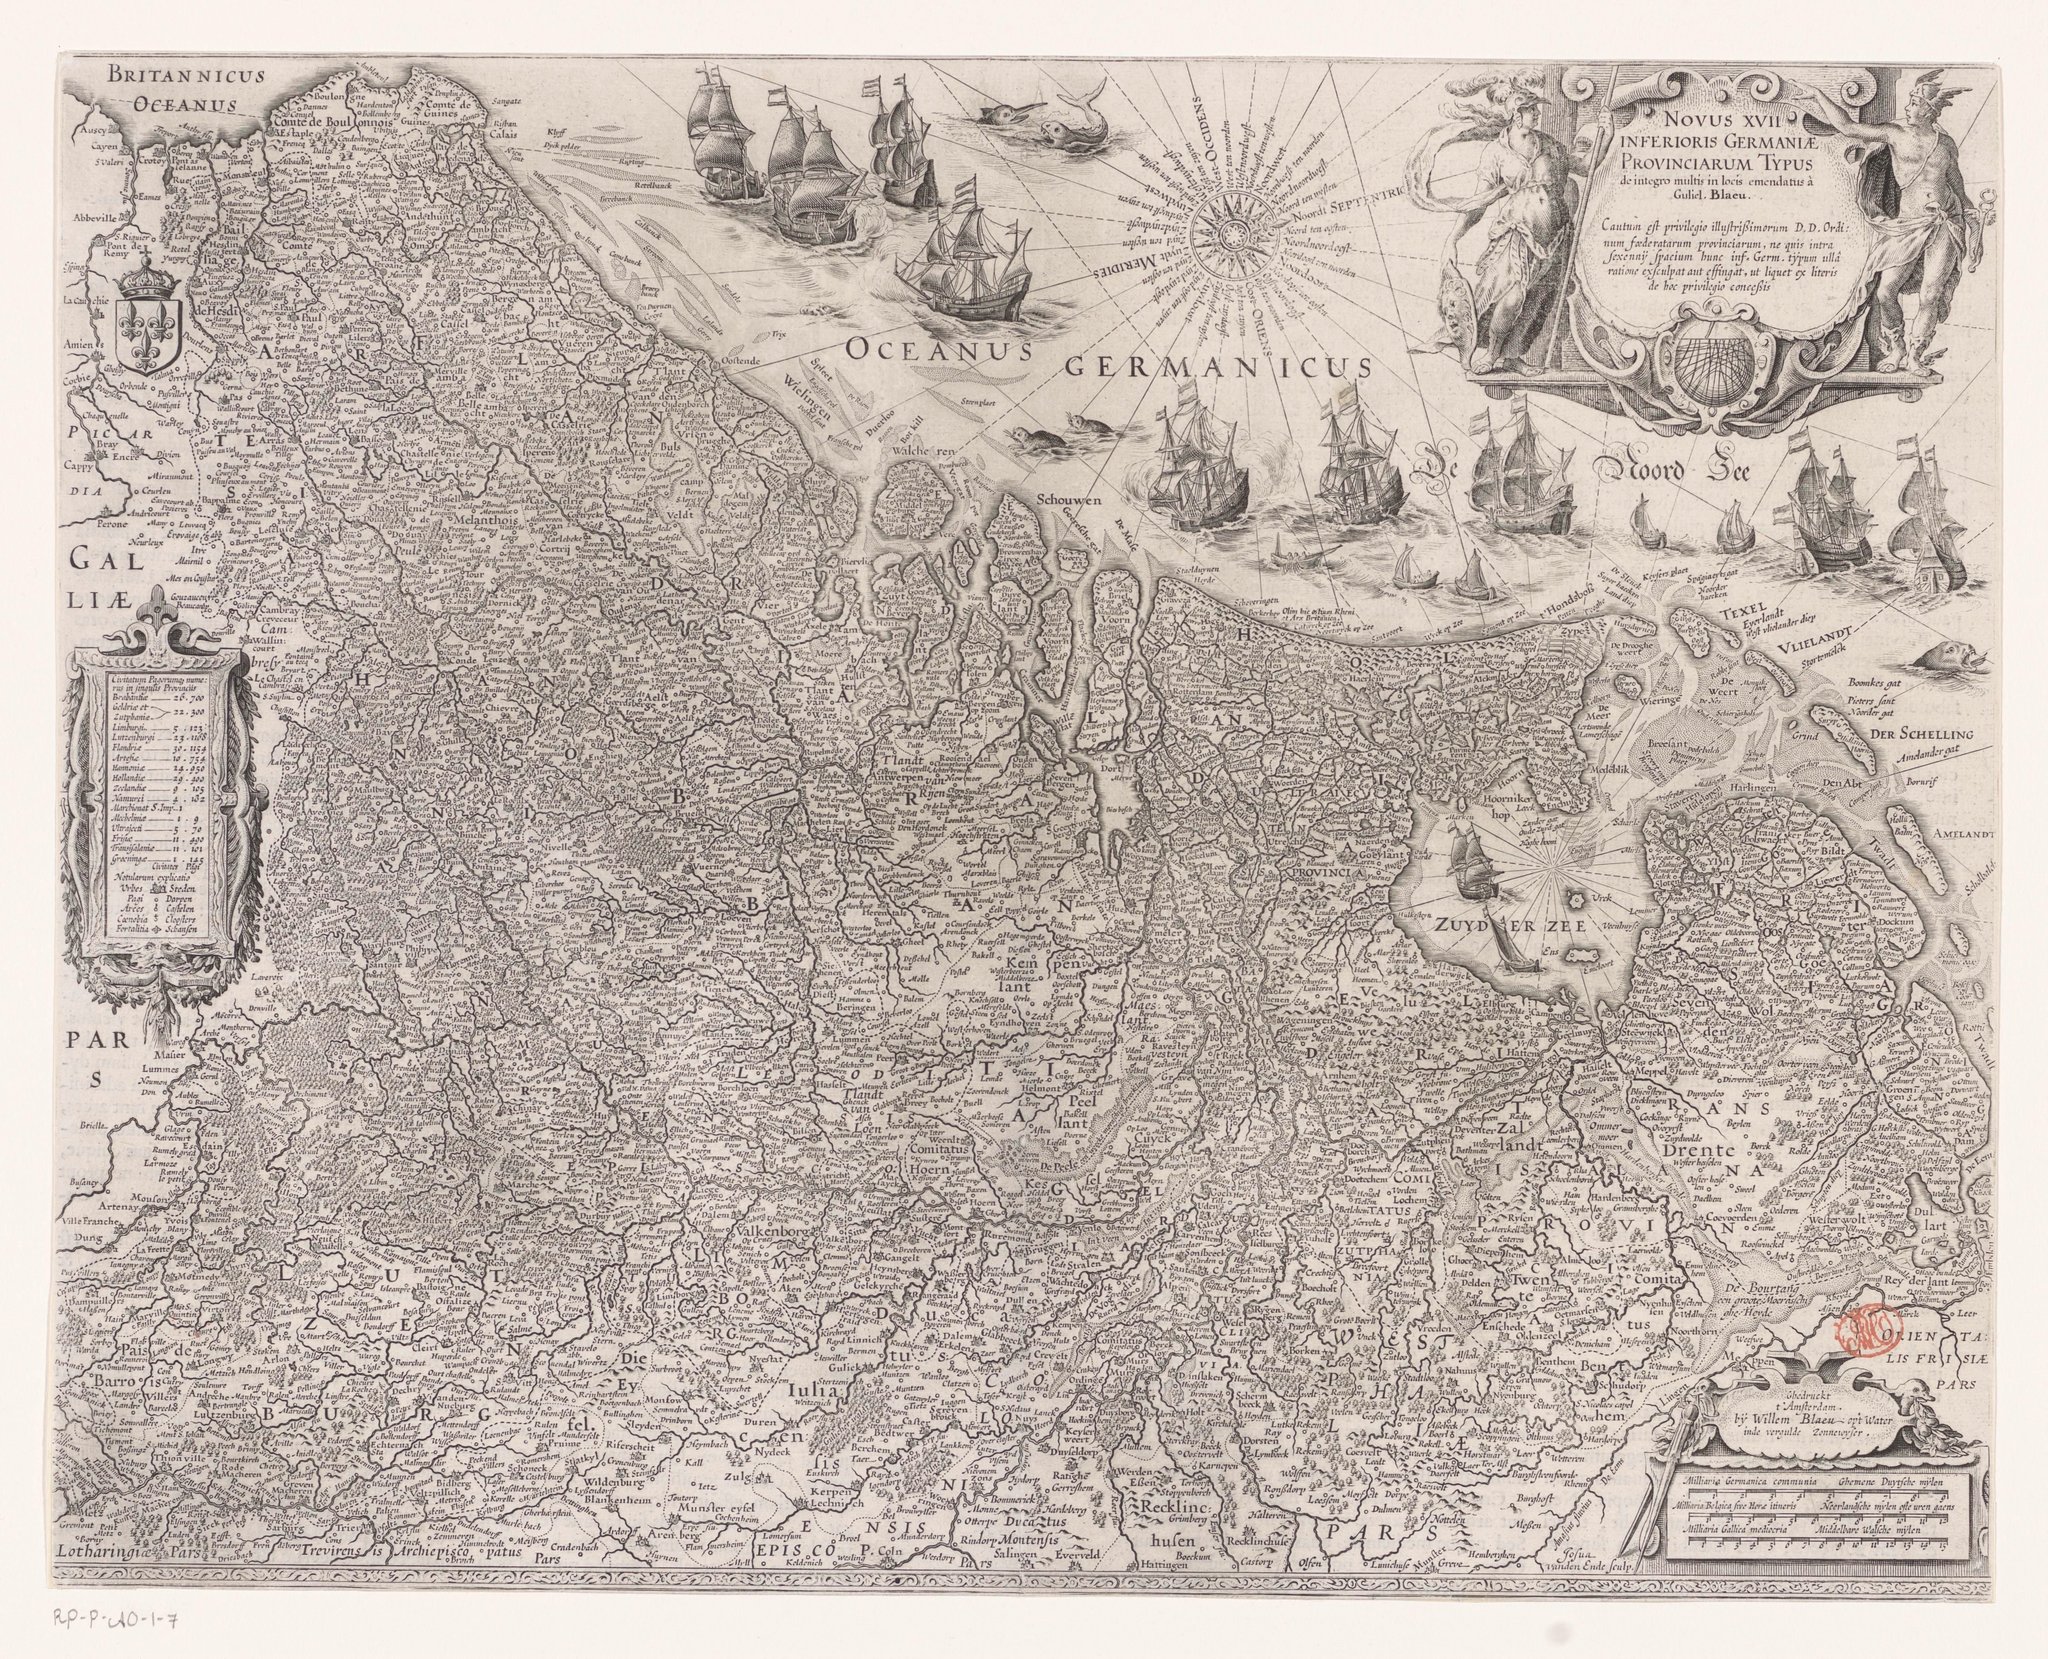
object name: map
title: Kaart van de Zeventien Provinciën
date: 1608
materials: paper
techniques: engraving, etching, letterpress printing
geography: amsterdam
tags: maps of separate countries or regions, (story of) minerva (pallas, athena), (story of) mercury (hermes), instruments used in geodesy, surveying instruments, low countries, belgium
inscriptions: collector's mark: Lugt 195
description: Kaart van de Zeventien Provinciën. In de zee zeilschepen, vissen en zeehonden. Rechtsboven de titelcartouche met links Minerva en rechts Mercurius. Links een cartouche met legenda en informatie over het aantal steden in iedere provincie. Rechtsonder een cartouche met drie schaalstokken: 9 Milliaria Germanica communia / 12 Milliaria Belgica /15 Milliaria Gallica mediocria. Linksboven het wapen van het koninkrijk Frankrijk. Met Latijnse tekst op verso.